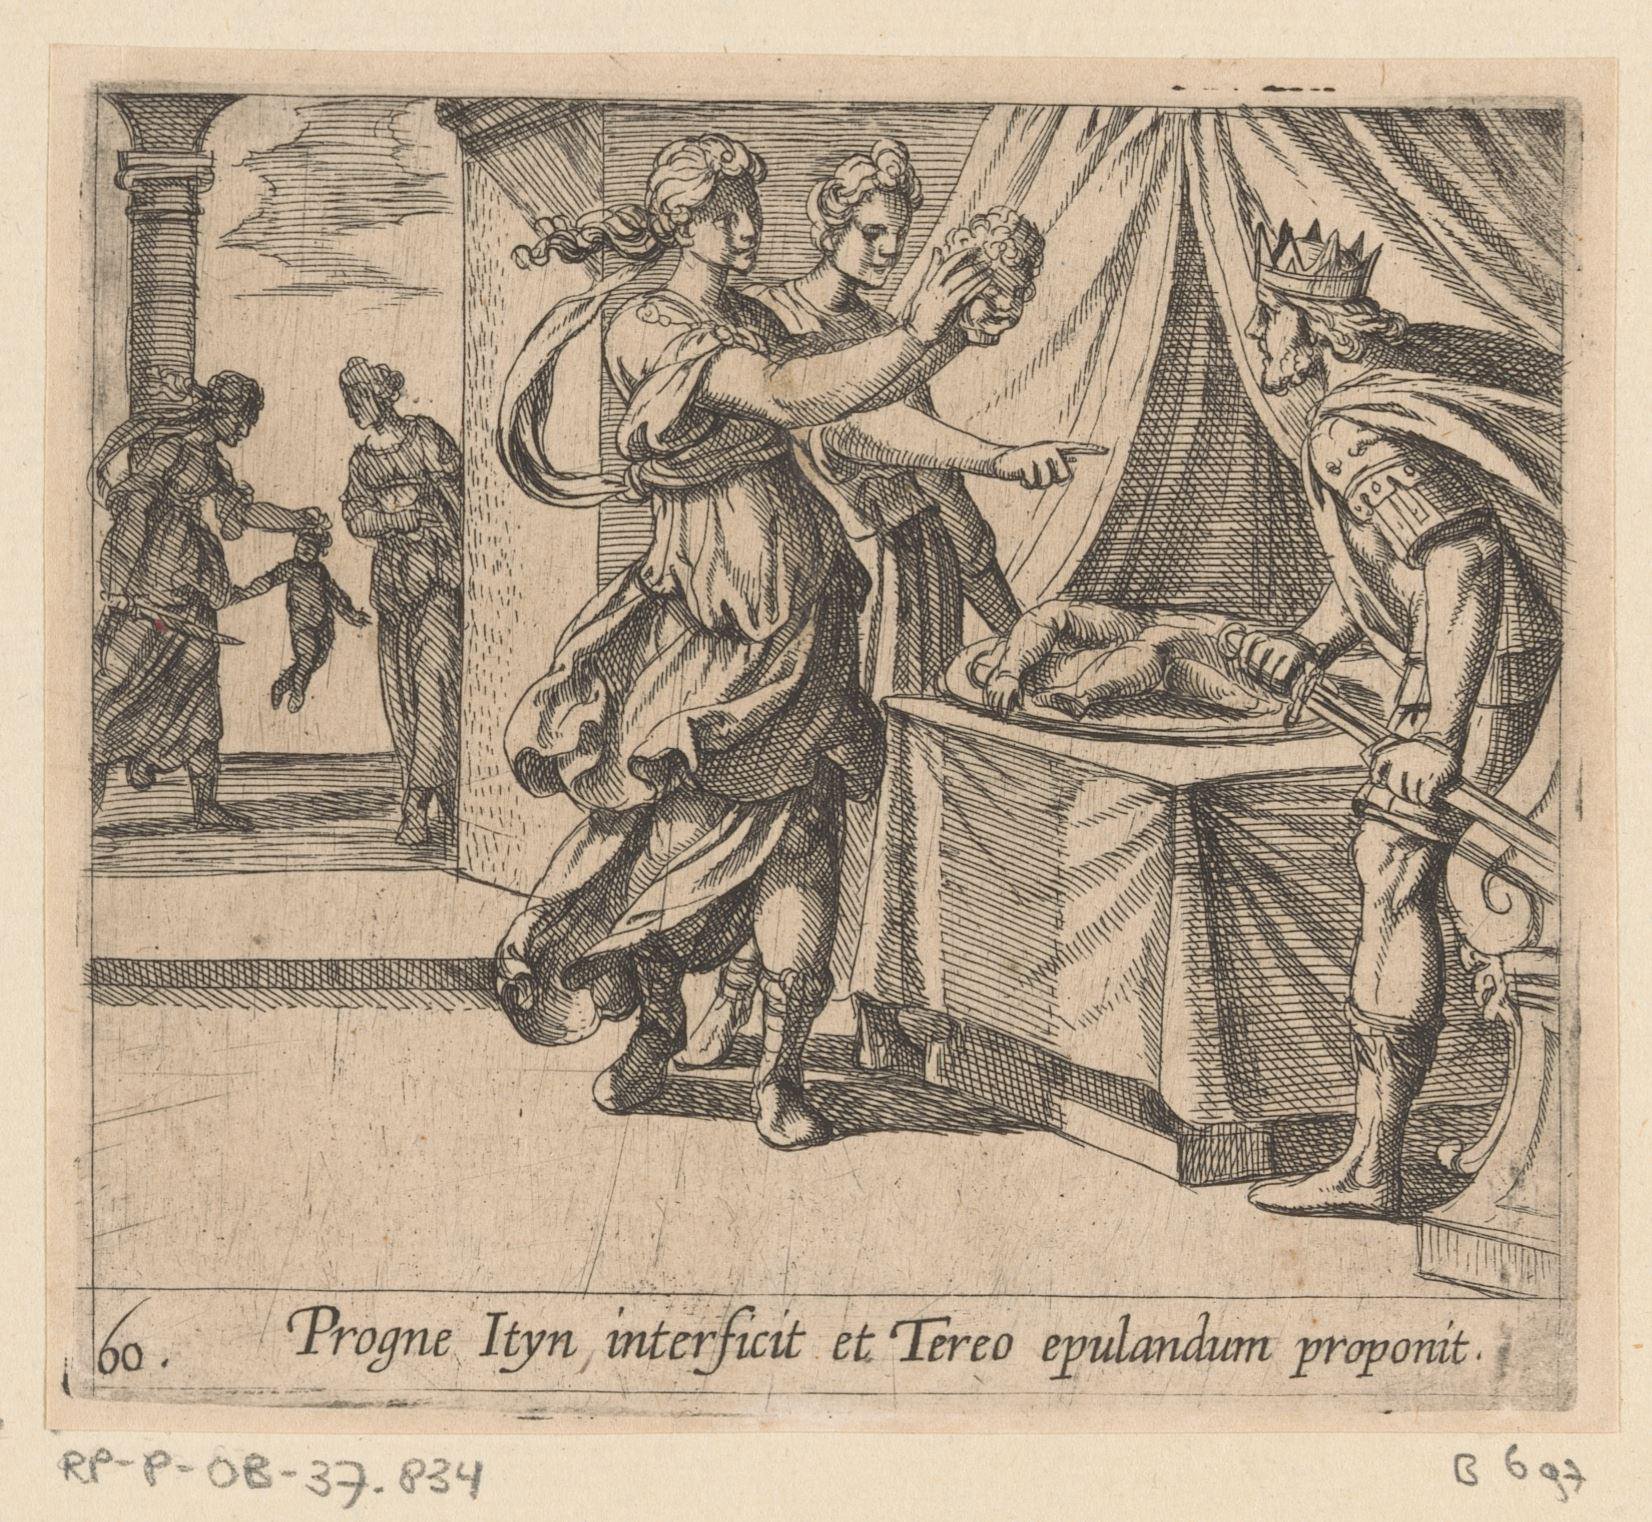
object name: print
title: Metamorfosen van Ovidius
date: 1606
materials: paper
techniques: etching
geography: antwerp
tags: (story of) philomela and procne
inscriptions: collector's mark: Lugt 240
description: Procne toont het afgehakte hoofd van Itys aan Tereus. Op tafel staat een schaal met andere afgehakte ledematen van Itys. Titel in het Latijn in ondermarge.